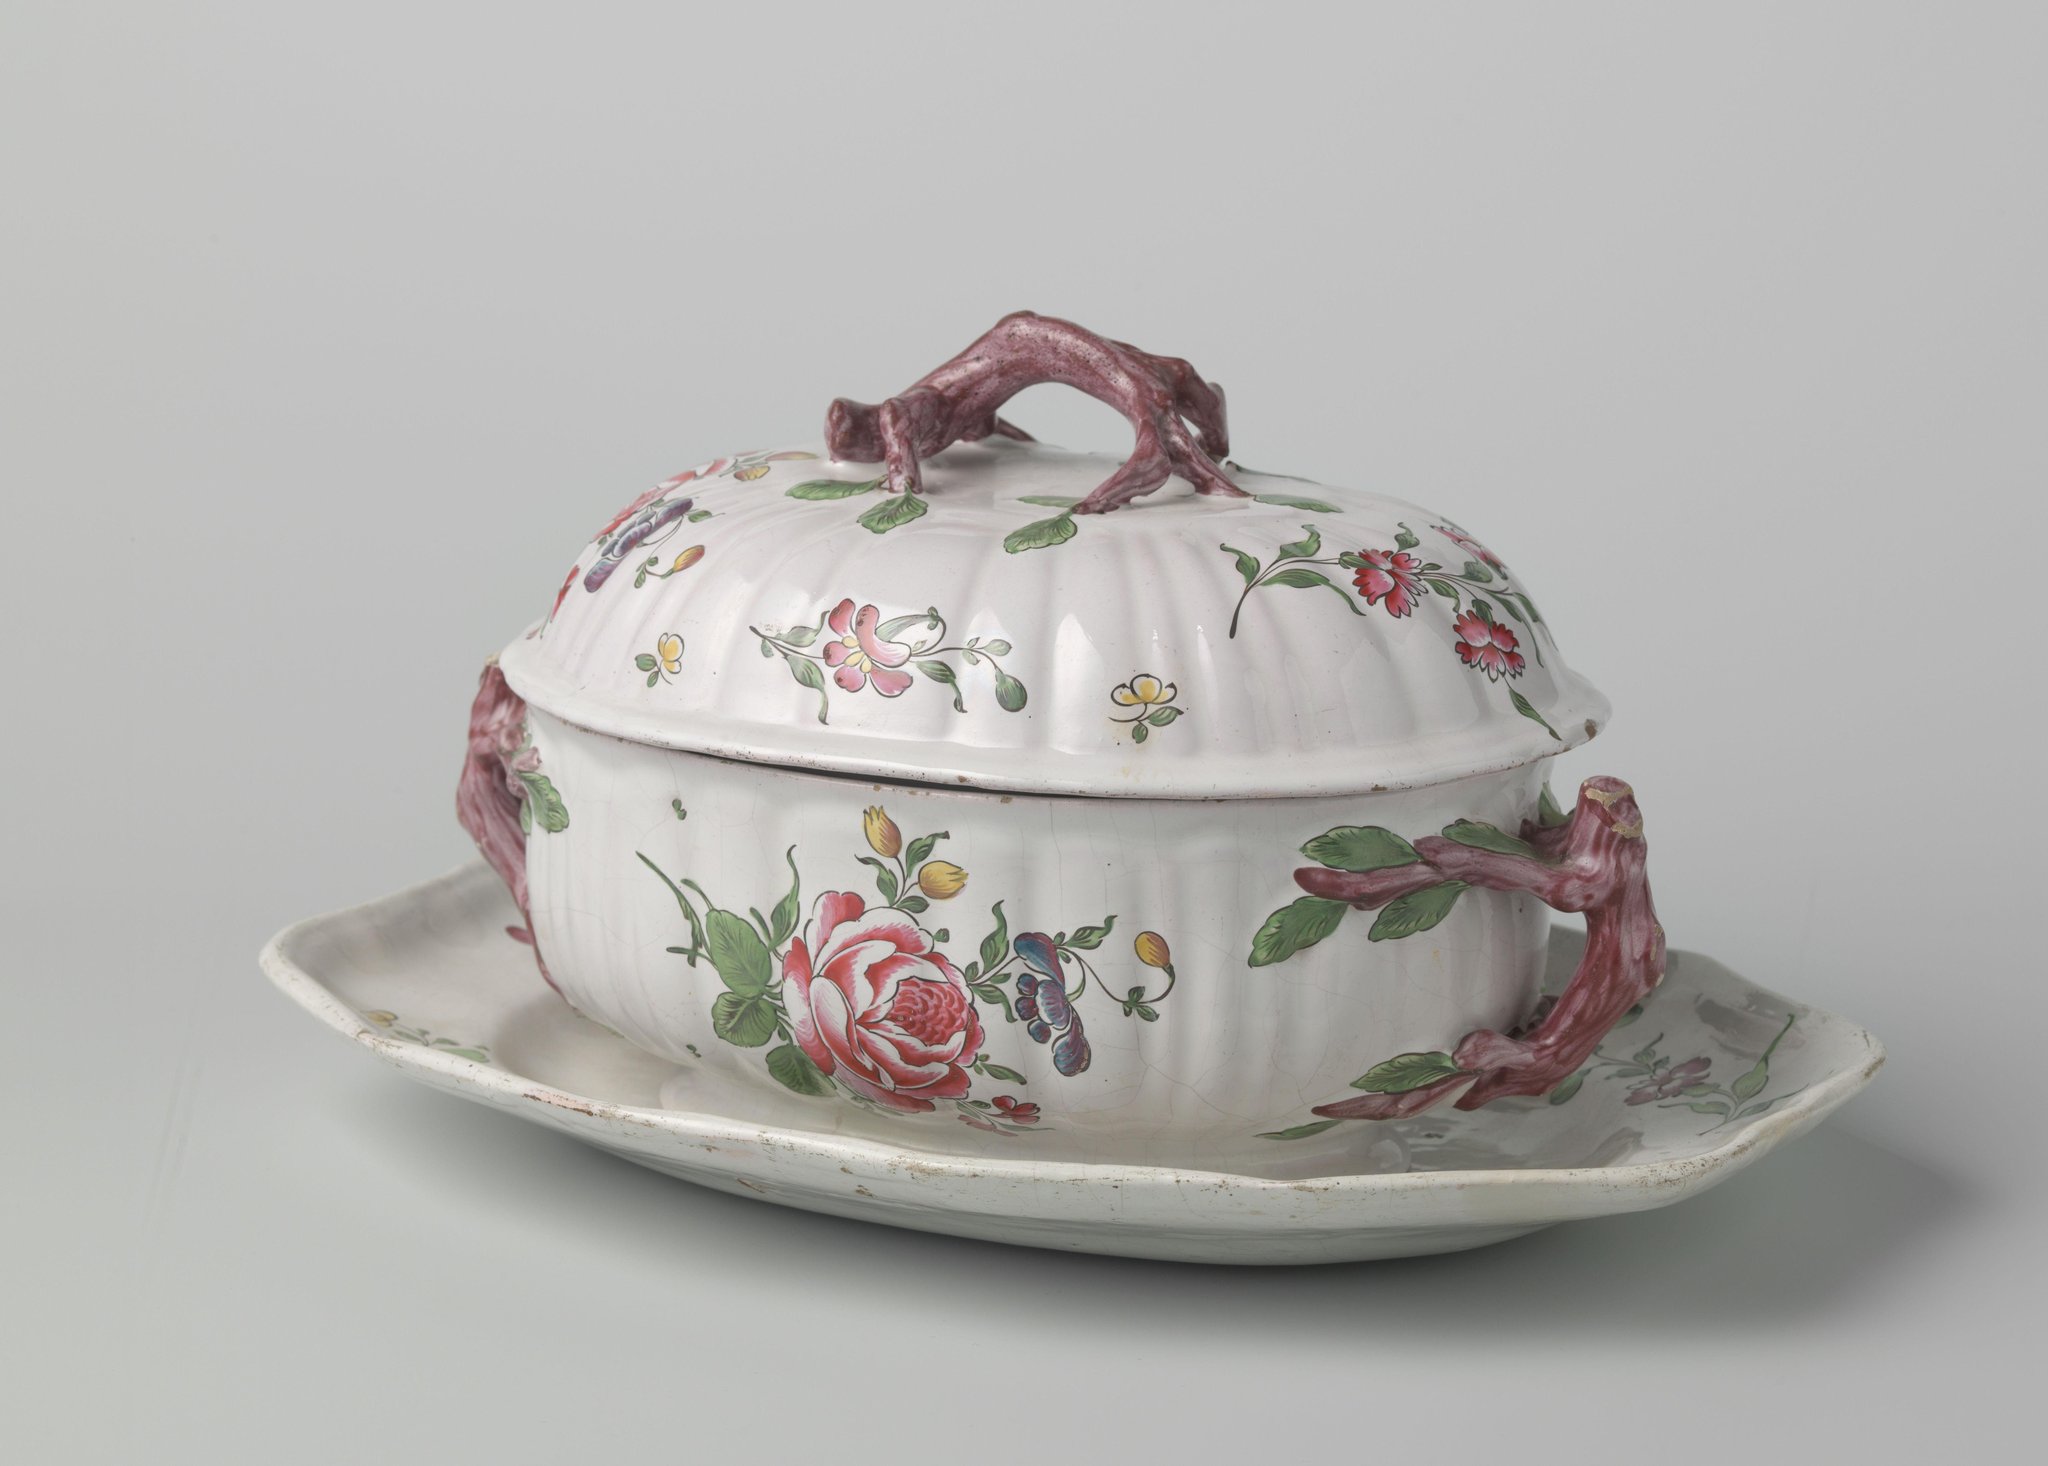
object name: platter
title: Onderschotel van terrine met deksel, beschilderd met bloemtakken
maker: Anonymous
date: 1760-1790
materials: earthenware, glaze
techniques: painted, polychromy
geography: france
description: Onderschotel van ovale terrine van veelkleurig beschilderde faience. De onderschotel heeft een gelobde rand. Beschilderd met bloemtakken.